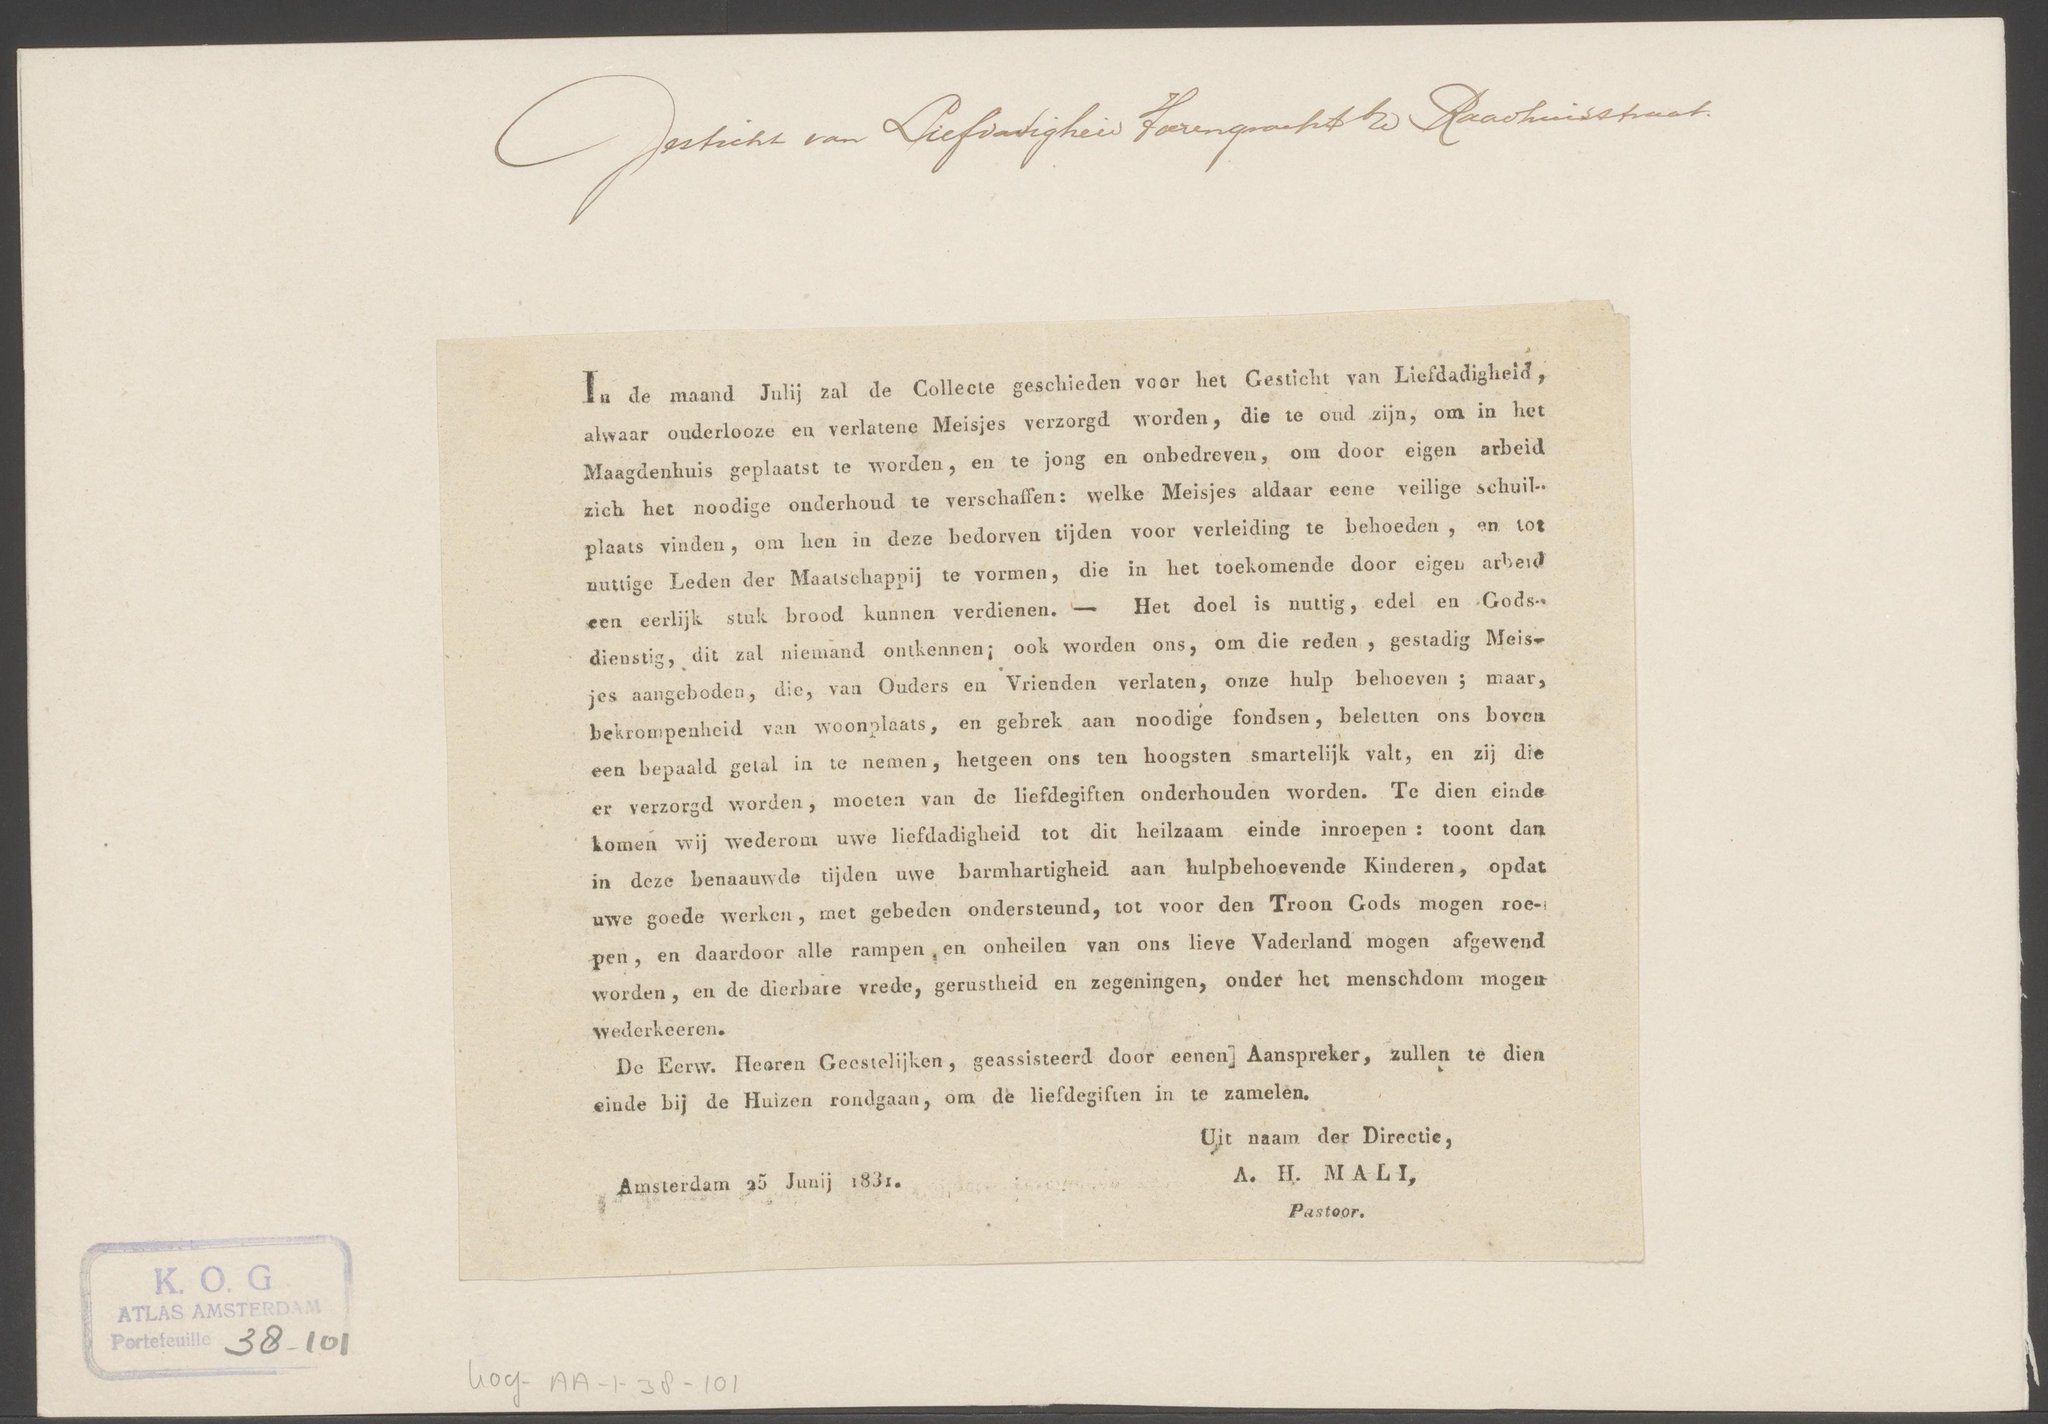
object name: text sheet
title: Aankondiging van collecte voor het Gesticht voor Liefdadigheid te Amsterdam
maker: antonius hubertus mali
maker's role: priest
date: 1831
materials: paper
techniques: letterpress printing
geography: amsterdam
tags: orphanage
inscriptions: collector's mark: Lugt 1641b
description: Onderwerpsrubriek binnen de Atlas Amsterdam: Armwezen en liefdadige instellingen: II. Kerkelijke inrichtingen: R.C. Oude Vrouwen- en Mannenhuis (St. Jacobs Gesticht).